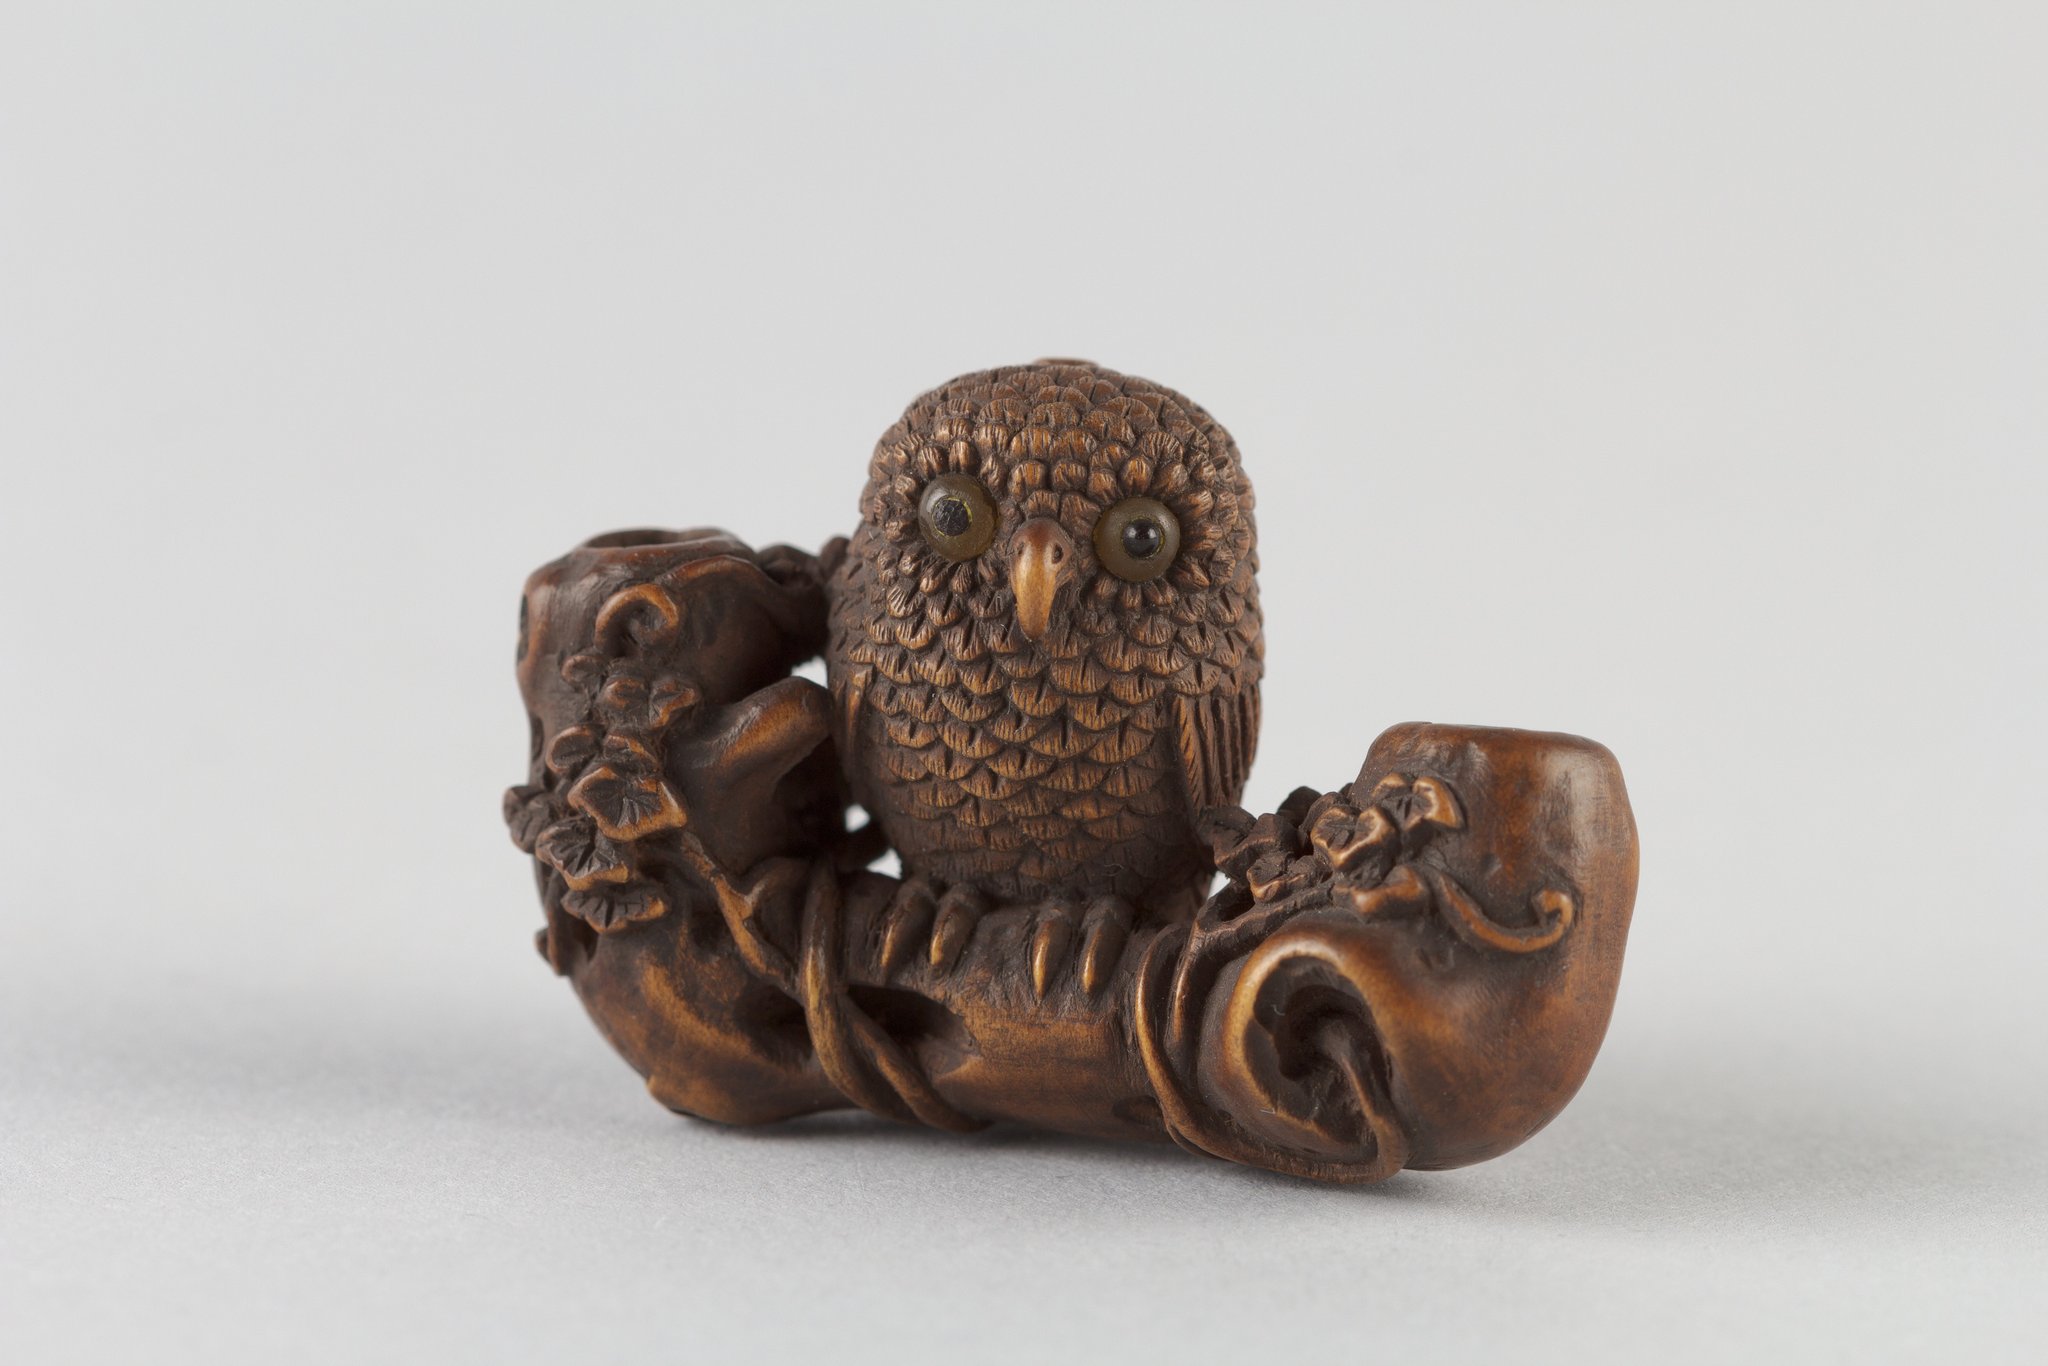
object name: netsuke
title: Netsuke of Owl on a Branch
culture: japanese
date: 1801-1900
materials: glass, wood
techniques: inlay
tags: owls